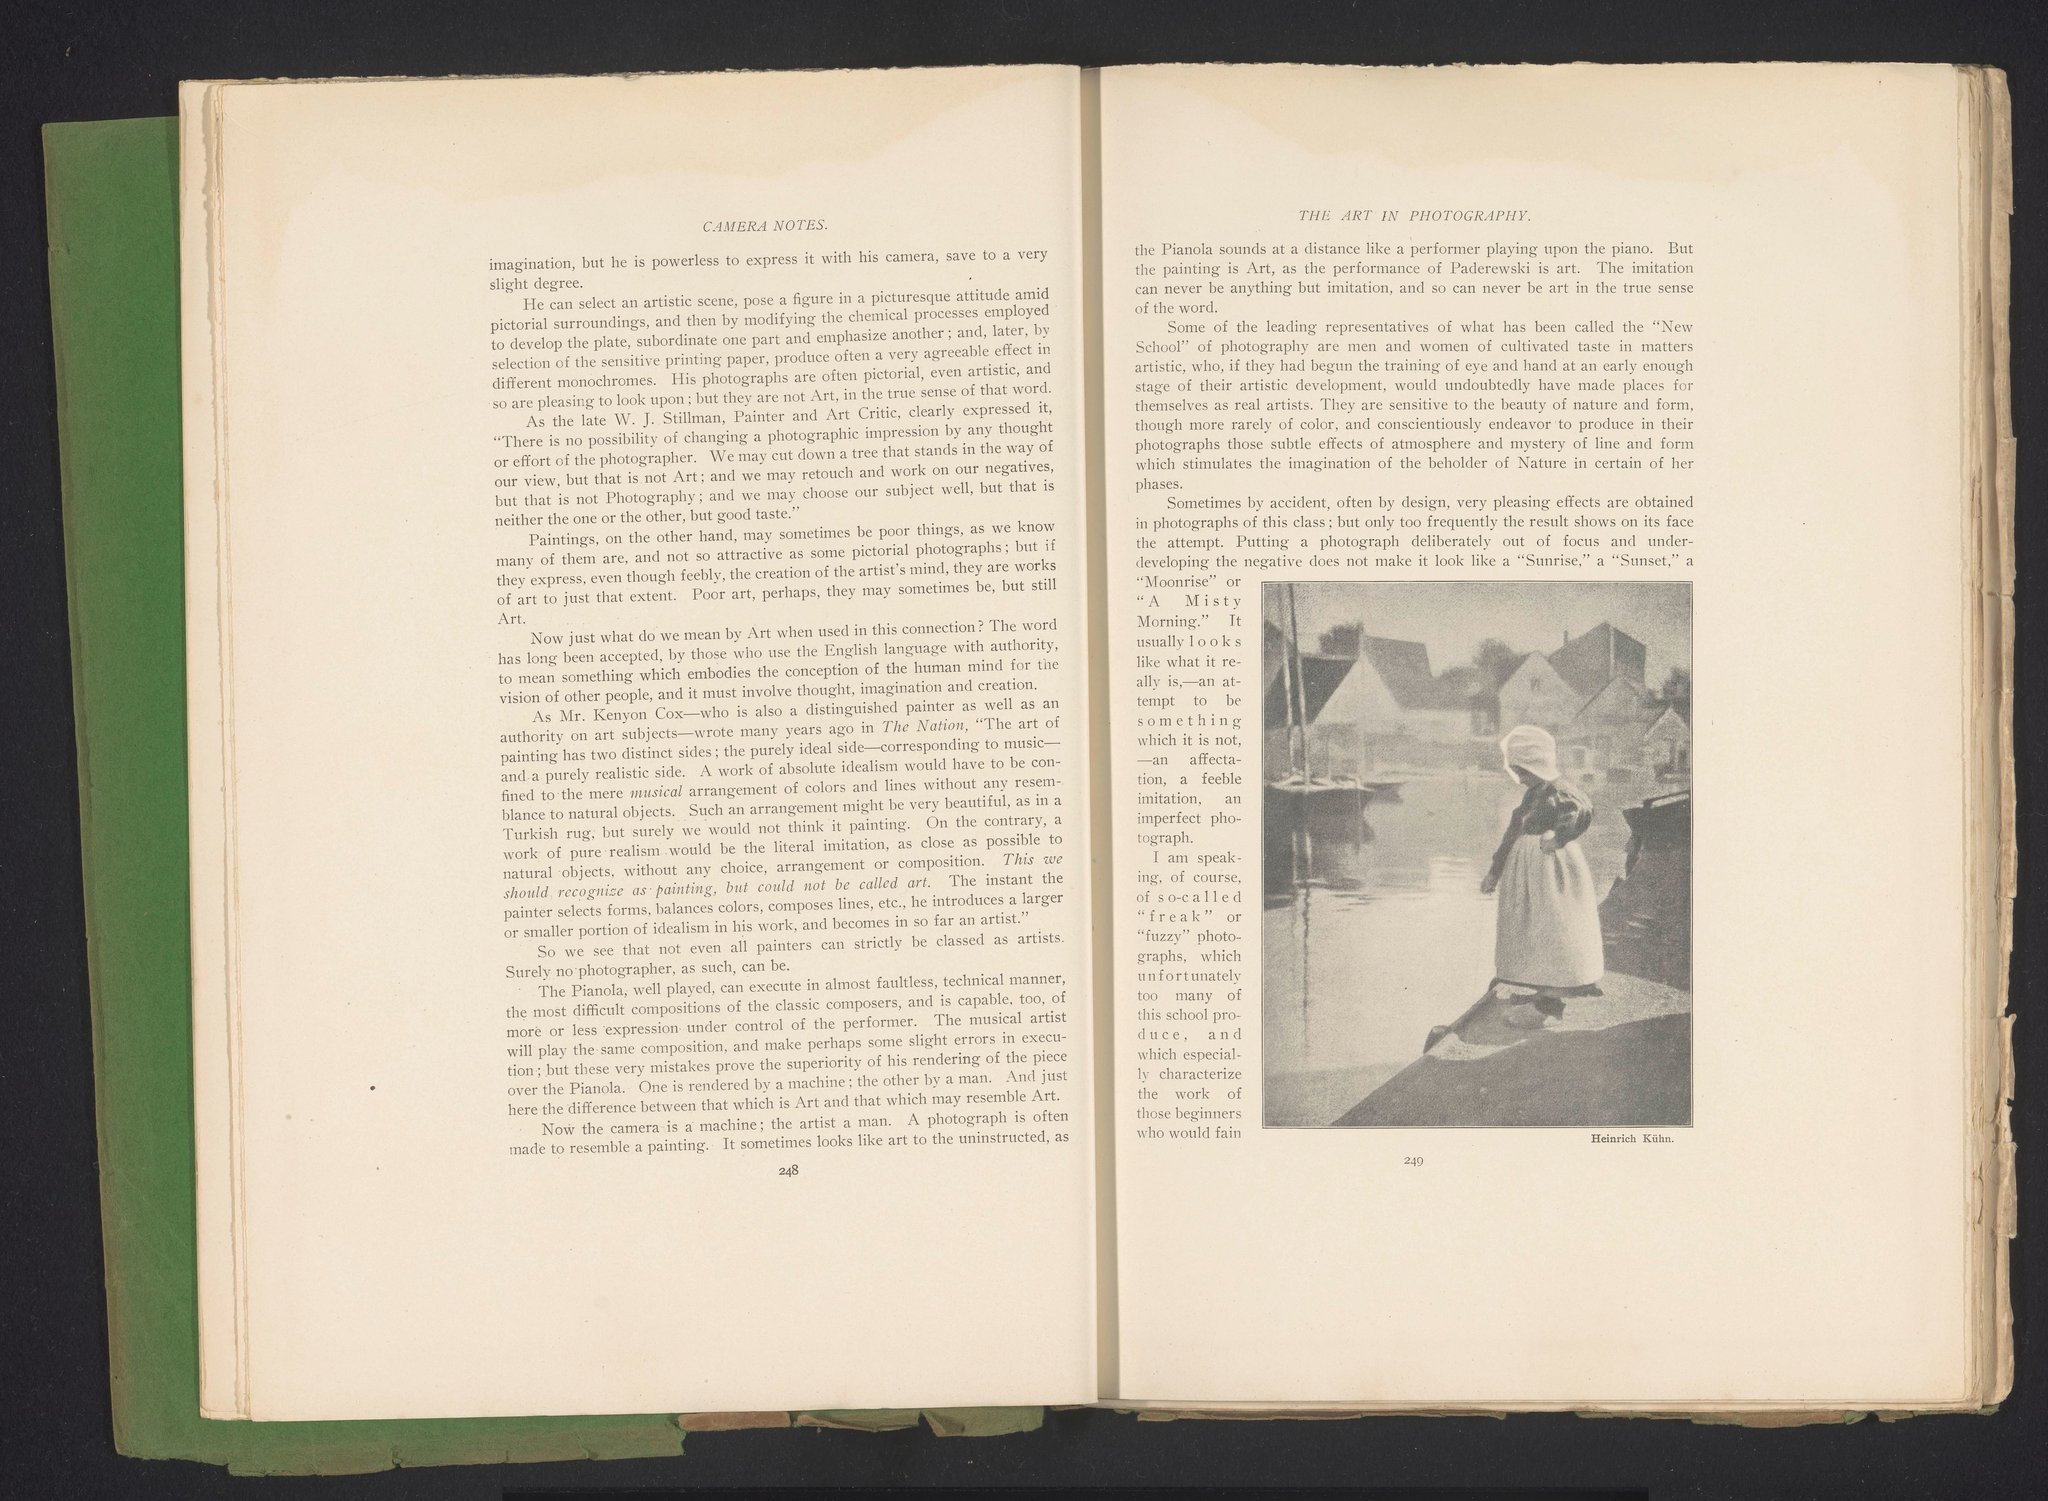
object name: photomechanical print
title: Meisje aan de waterkant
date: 1897-1902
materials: paper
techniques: autotype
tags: river bank, girl (child between toddler and youth)